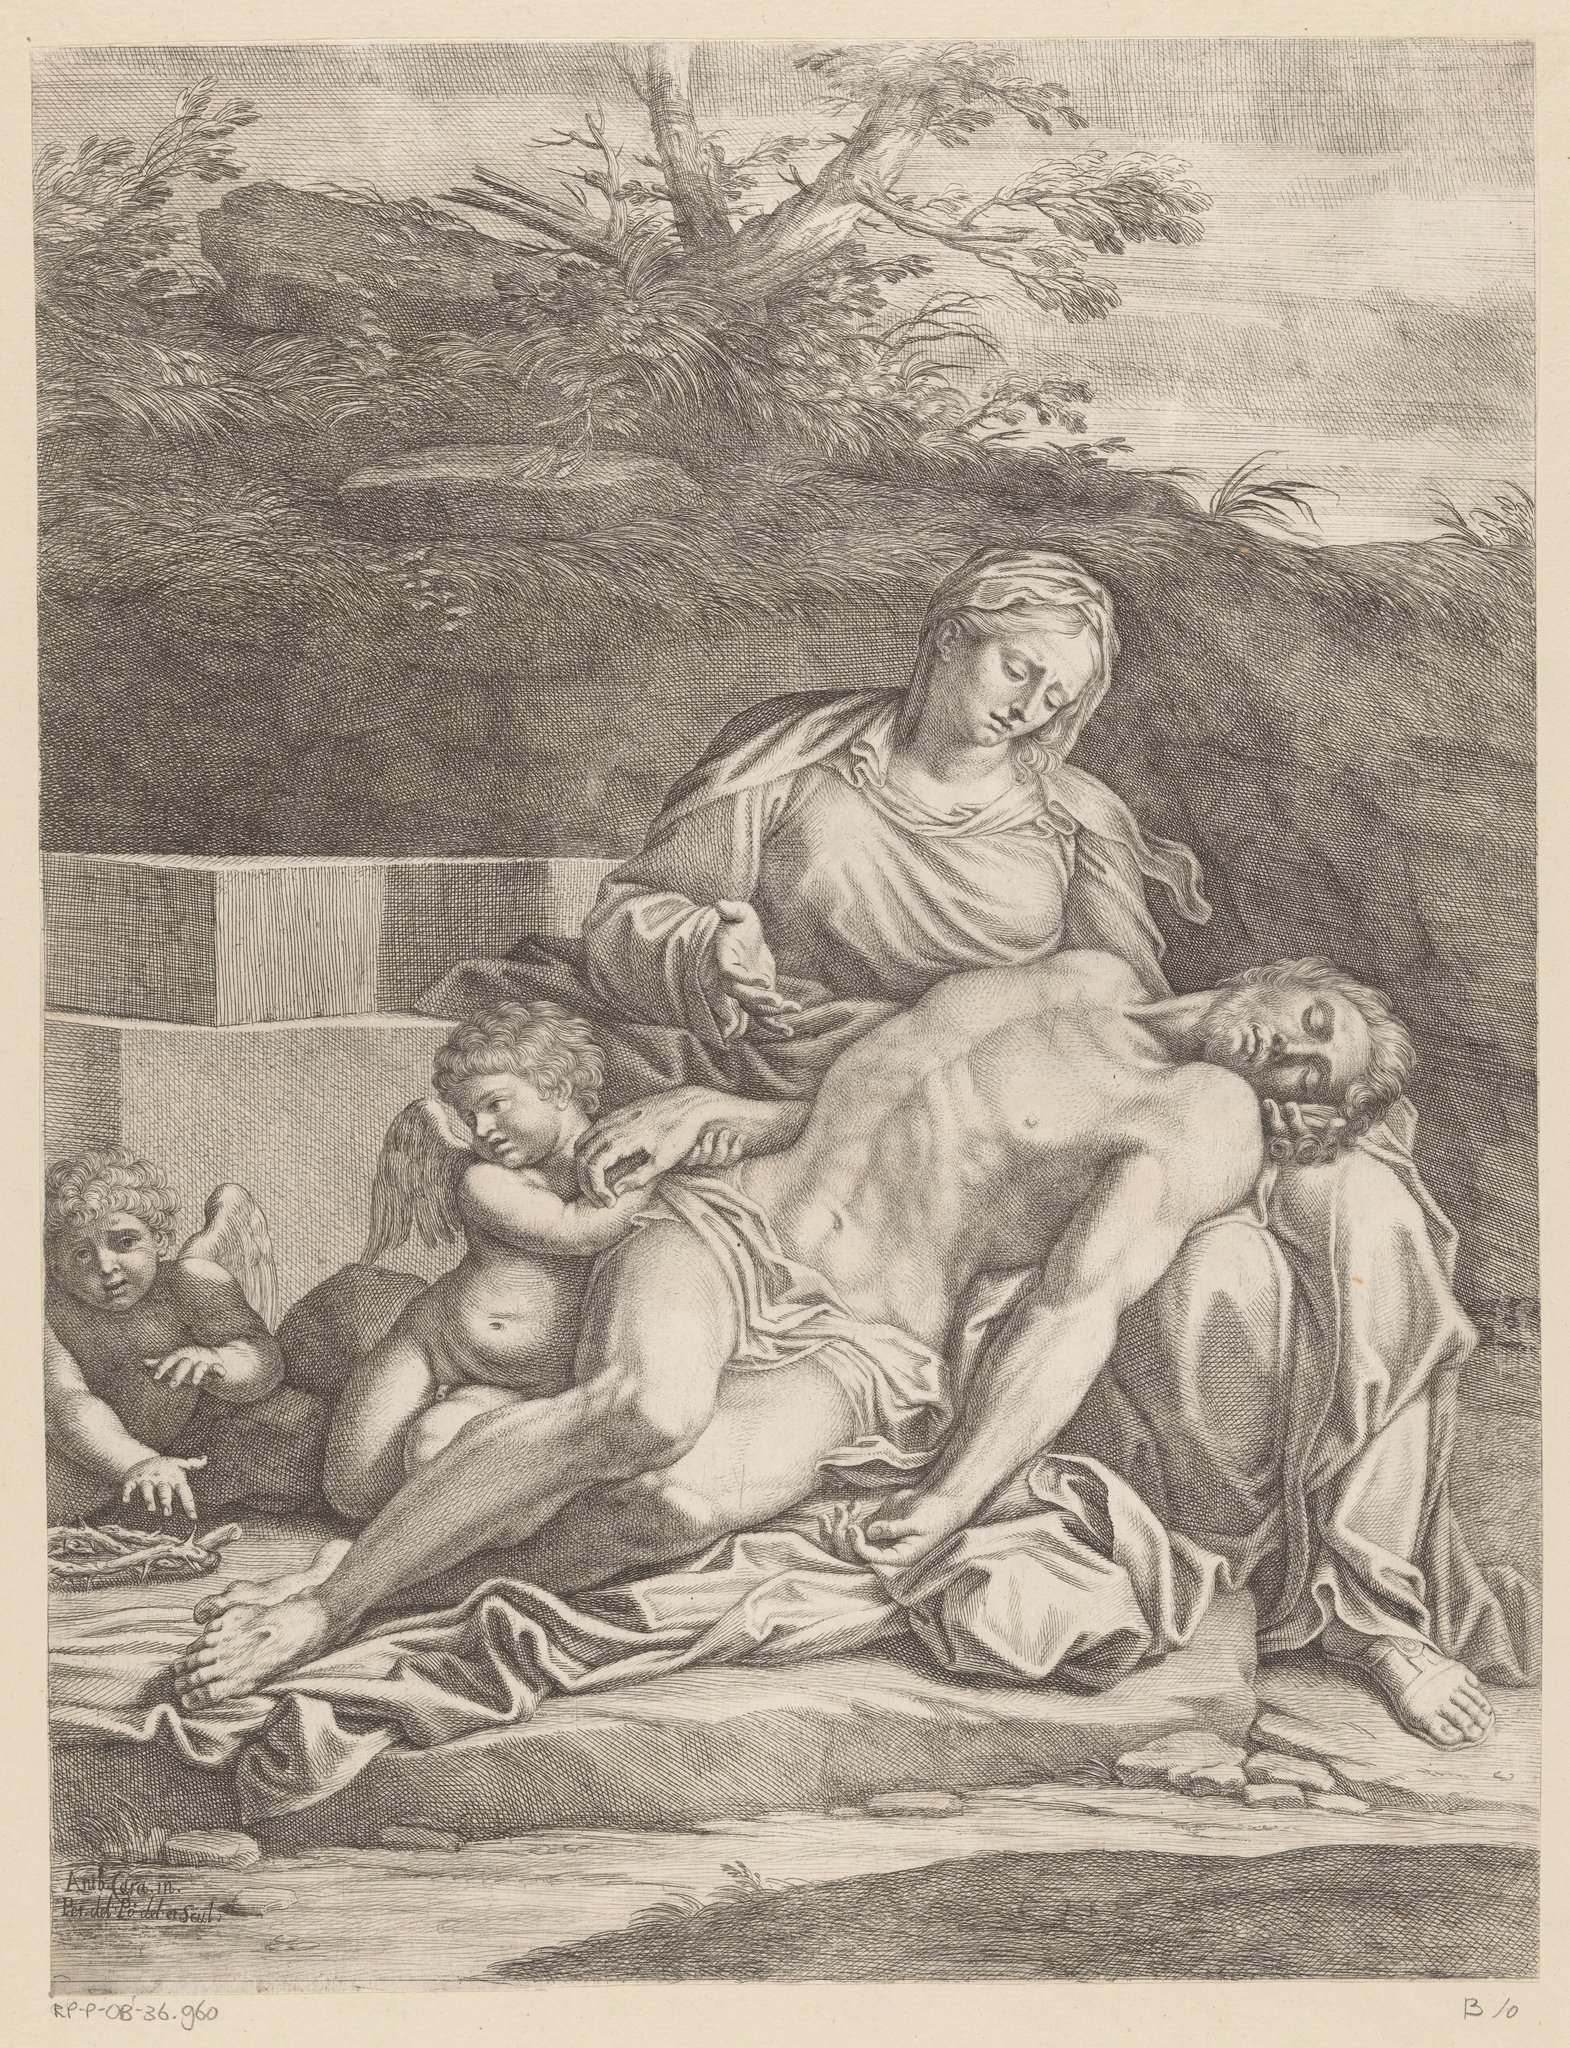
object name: print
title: Bewening van Maria en twee engelen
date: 1620-1692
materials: paper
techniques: etching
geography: italy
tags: lamentation over the dead christ by his relatives and friends (christ usually without crown of thorns)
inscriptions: collector's mark: Lugt 240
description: Maria en twee engelen treuren bij het lichaam van Christus. Een van de engelen prikt zijn vinger aan de doornenkroon die bij de voeten van Christus ligt.